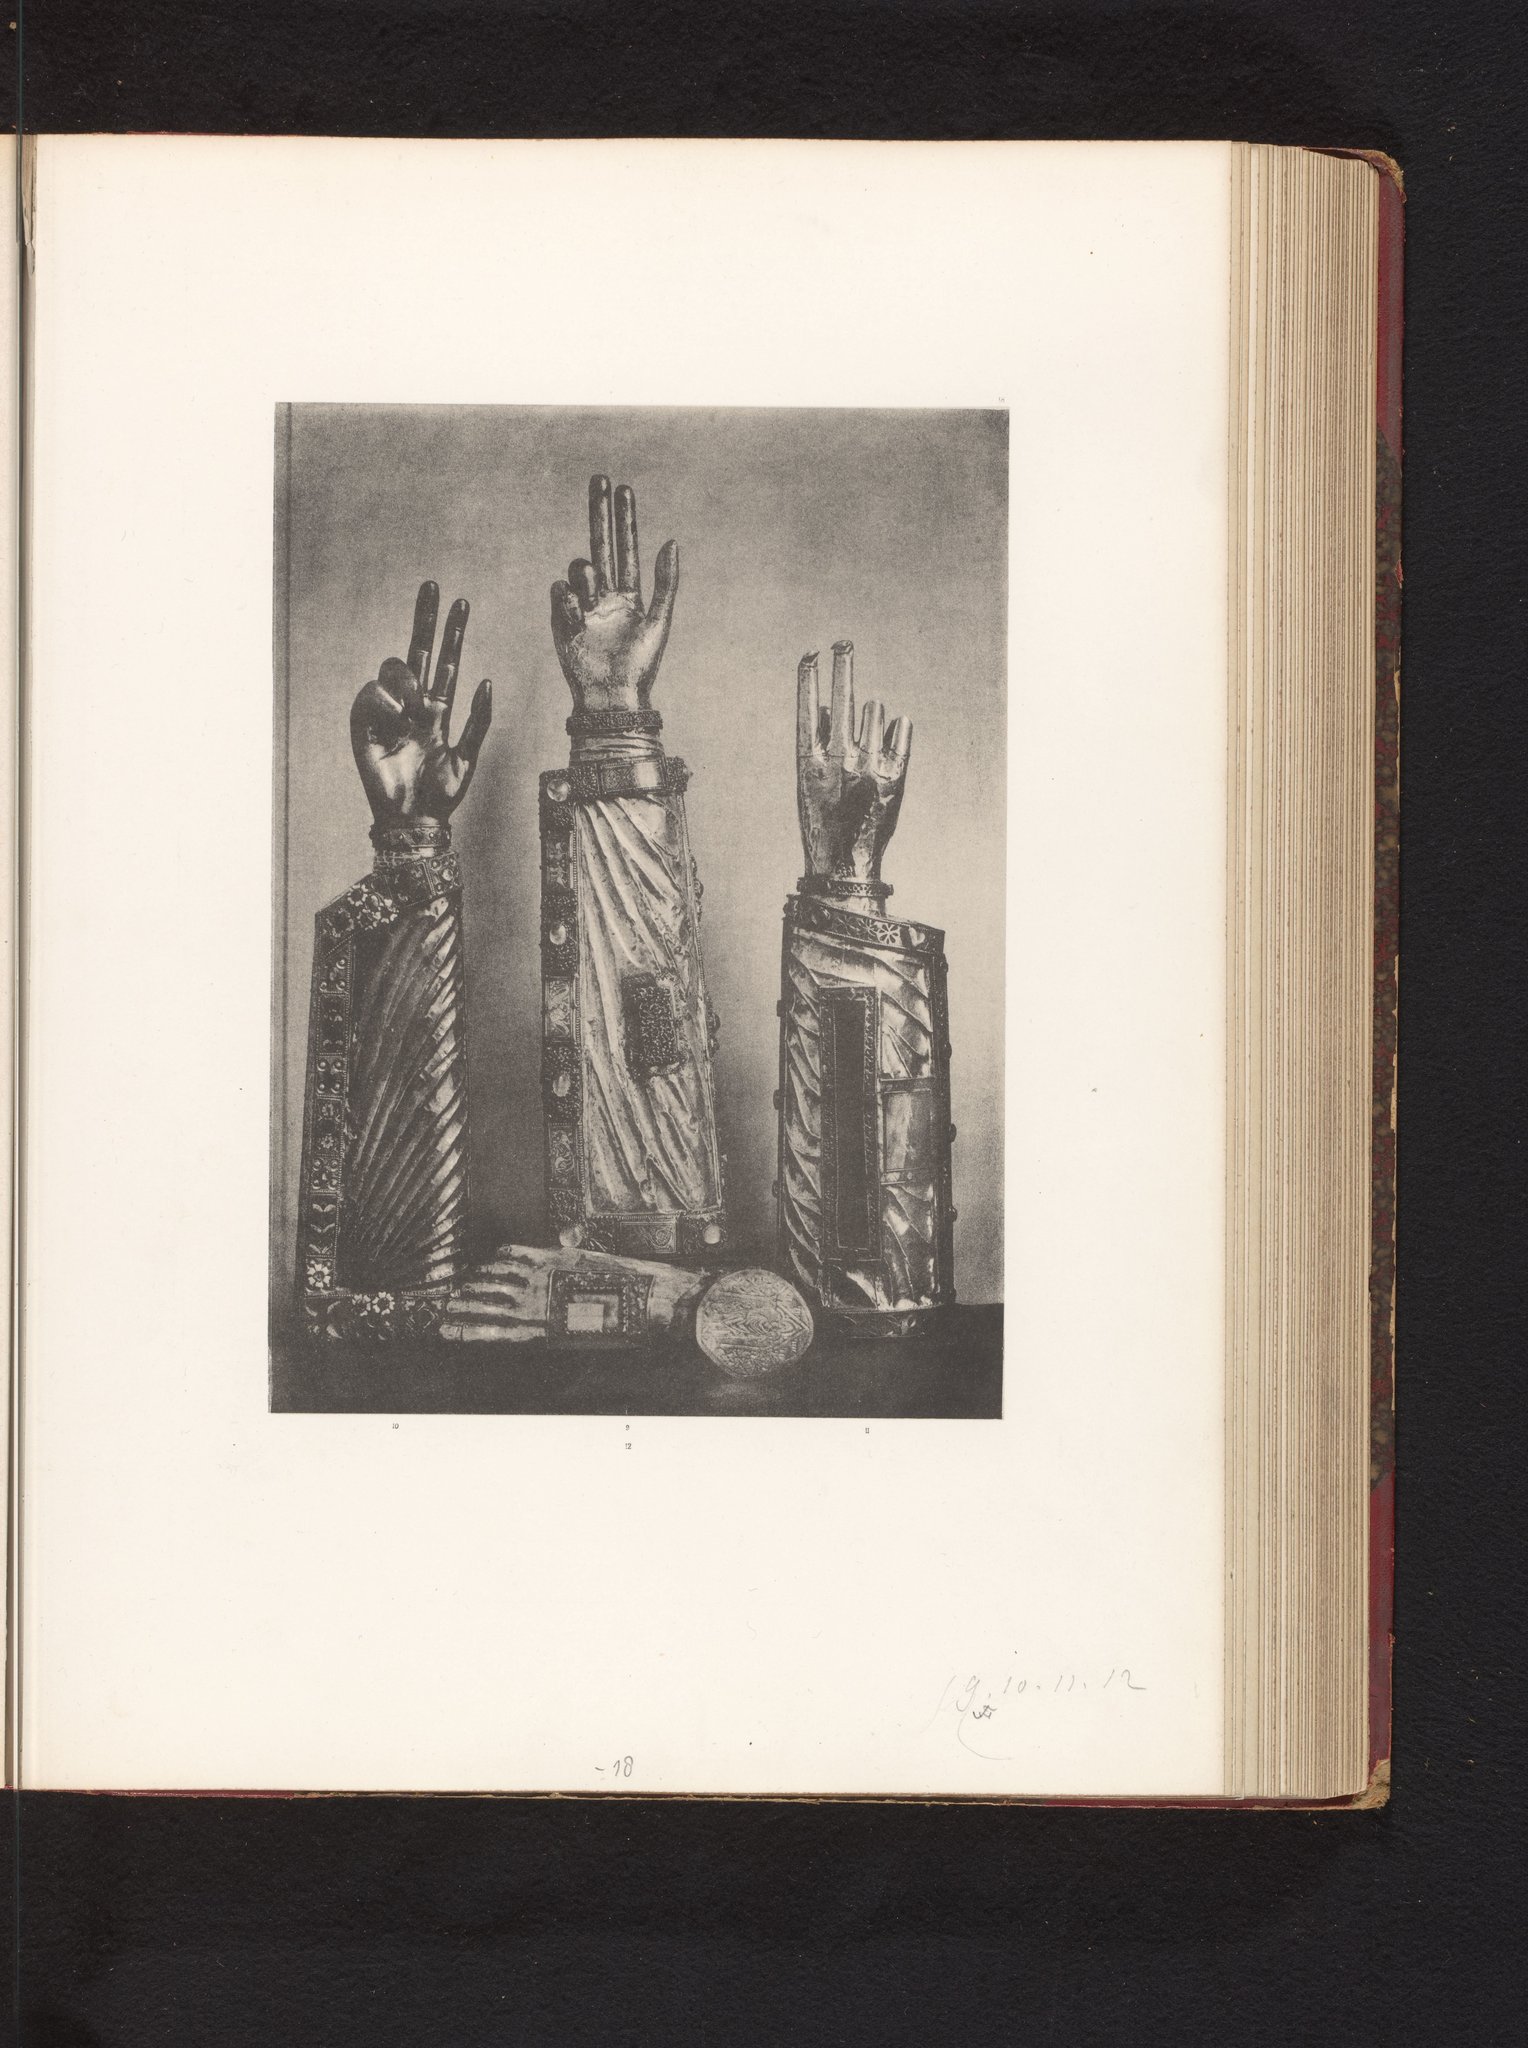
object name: page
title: Drie relikwieënkasten in de vorm van een hand en een relikwieënkast in de vorm van een voet, opgesteld op een tentoonstelling over religieuze objecten uit de middeleeuwen en renaissance in 1864 in Mechelen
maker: joseph maes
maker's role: fotograaf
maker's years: 1838-1908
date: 1864-1866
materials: paper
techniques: photolithography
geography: mechelen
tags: piece of sculpture, reproduction of a piece of sculpture (+ metals ~ arts), relics (and reliquaries), mechelen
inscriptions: number: ‘9. 10. 11. 12’, number: ‘10 - 9 - 11/ 12’, number: ‘-18’